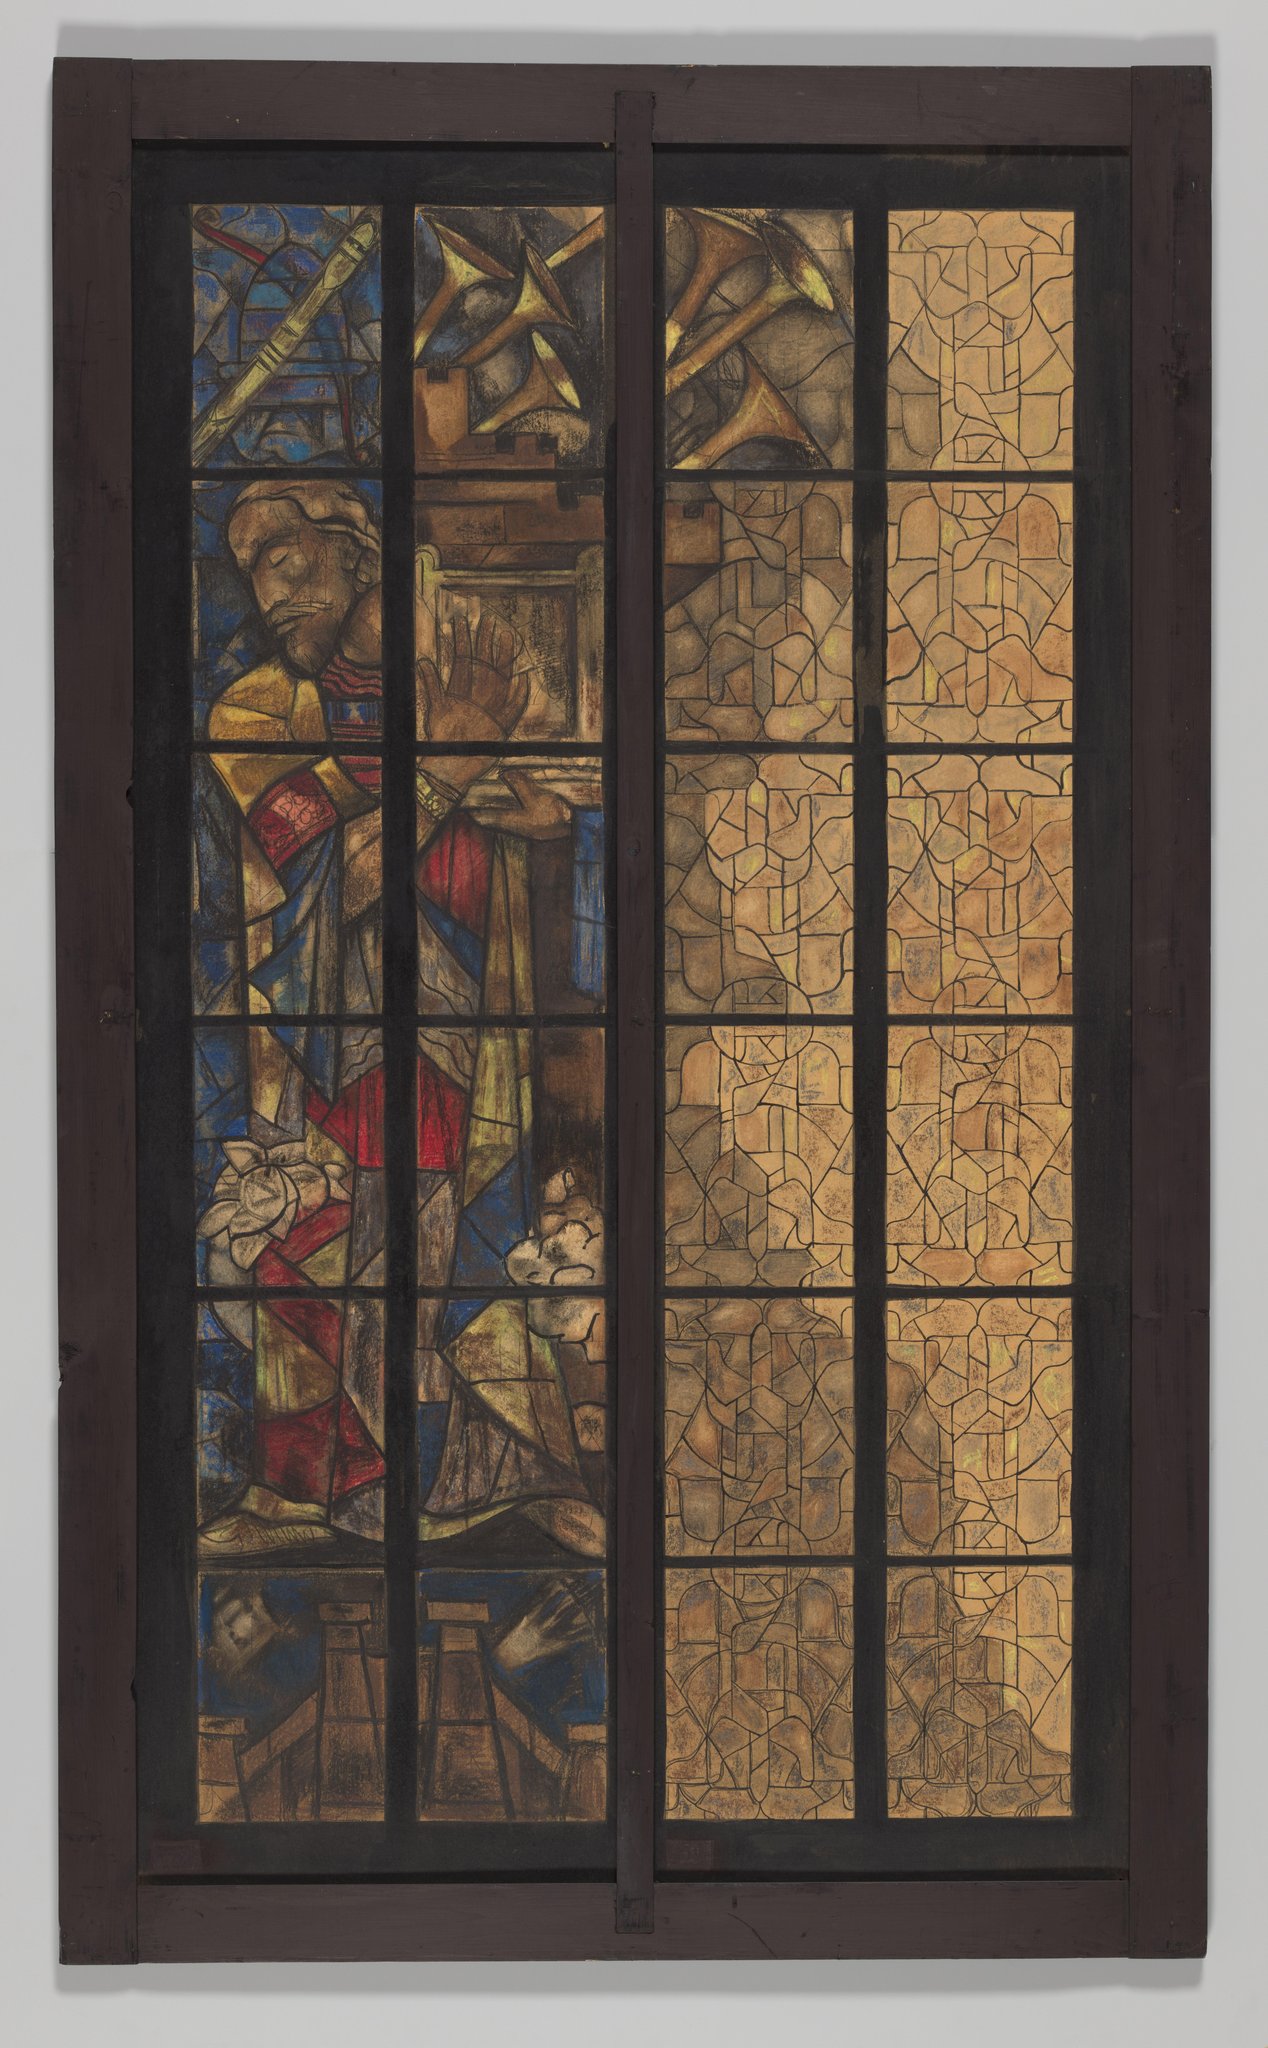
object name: drawing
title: Ontwerp voor het midden gedeelte van een raam in het Noordertransept in de Dom te Utrecht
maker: richard nicolaüs roland holst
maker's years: 1868-1938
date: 1878-1938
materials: cardboard, chalk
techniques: brush